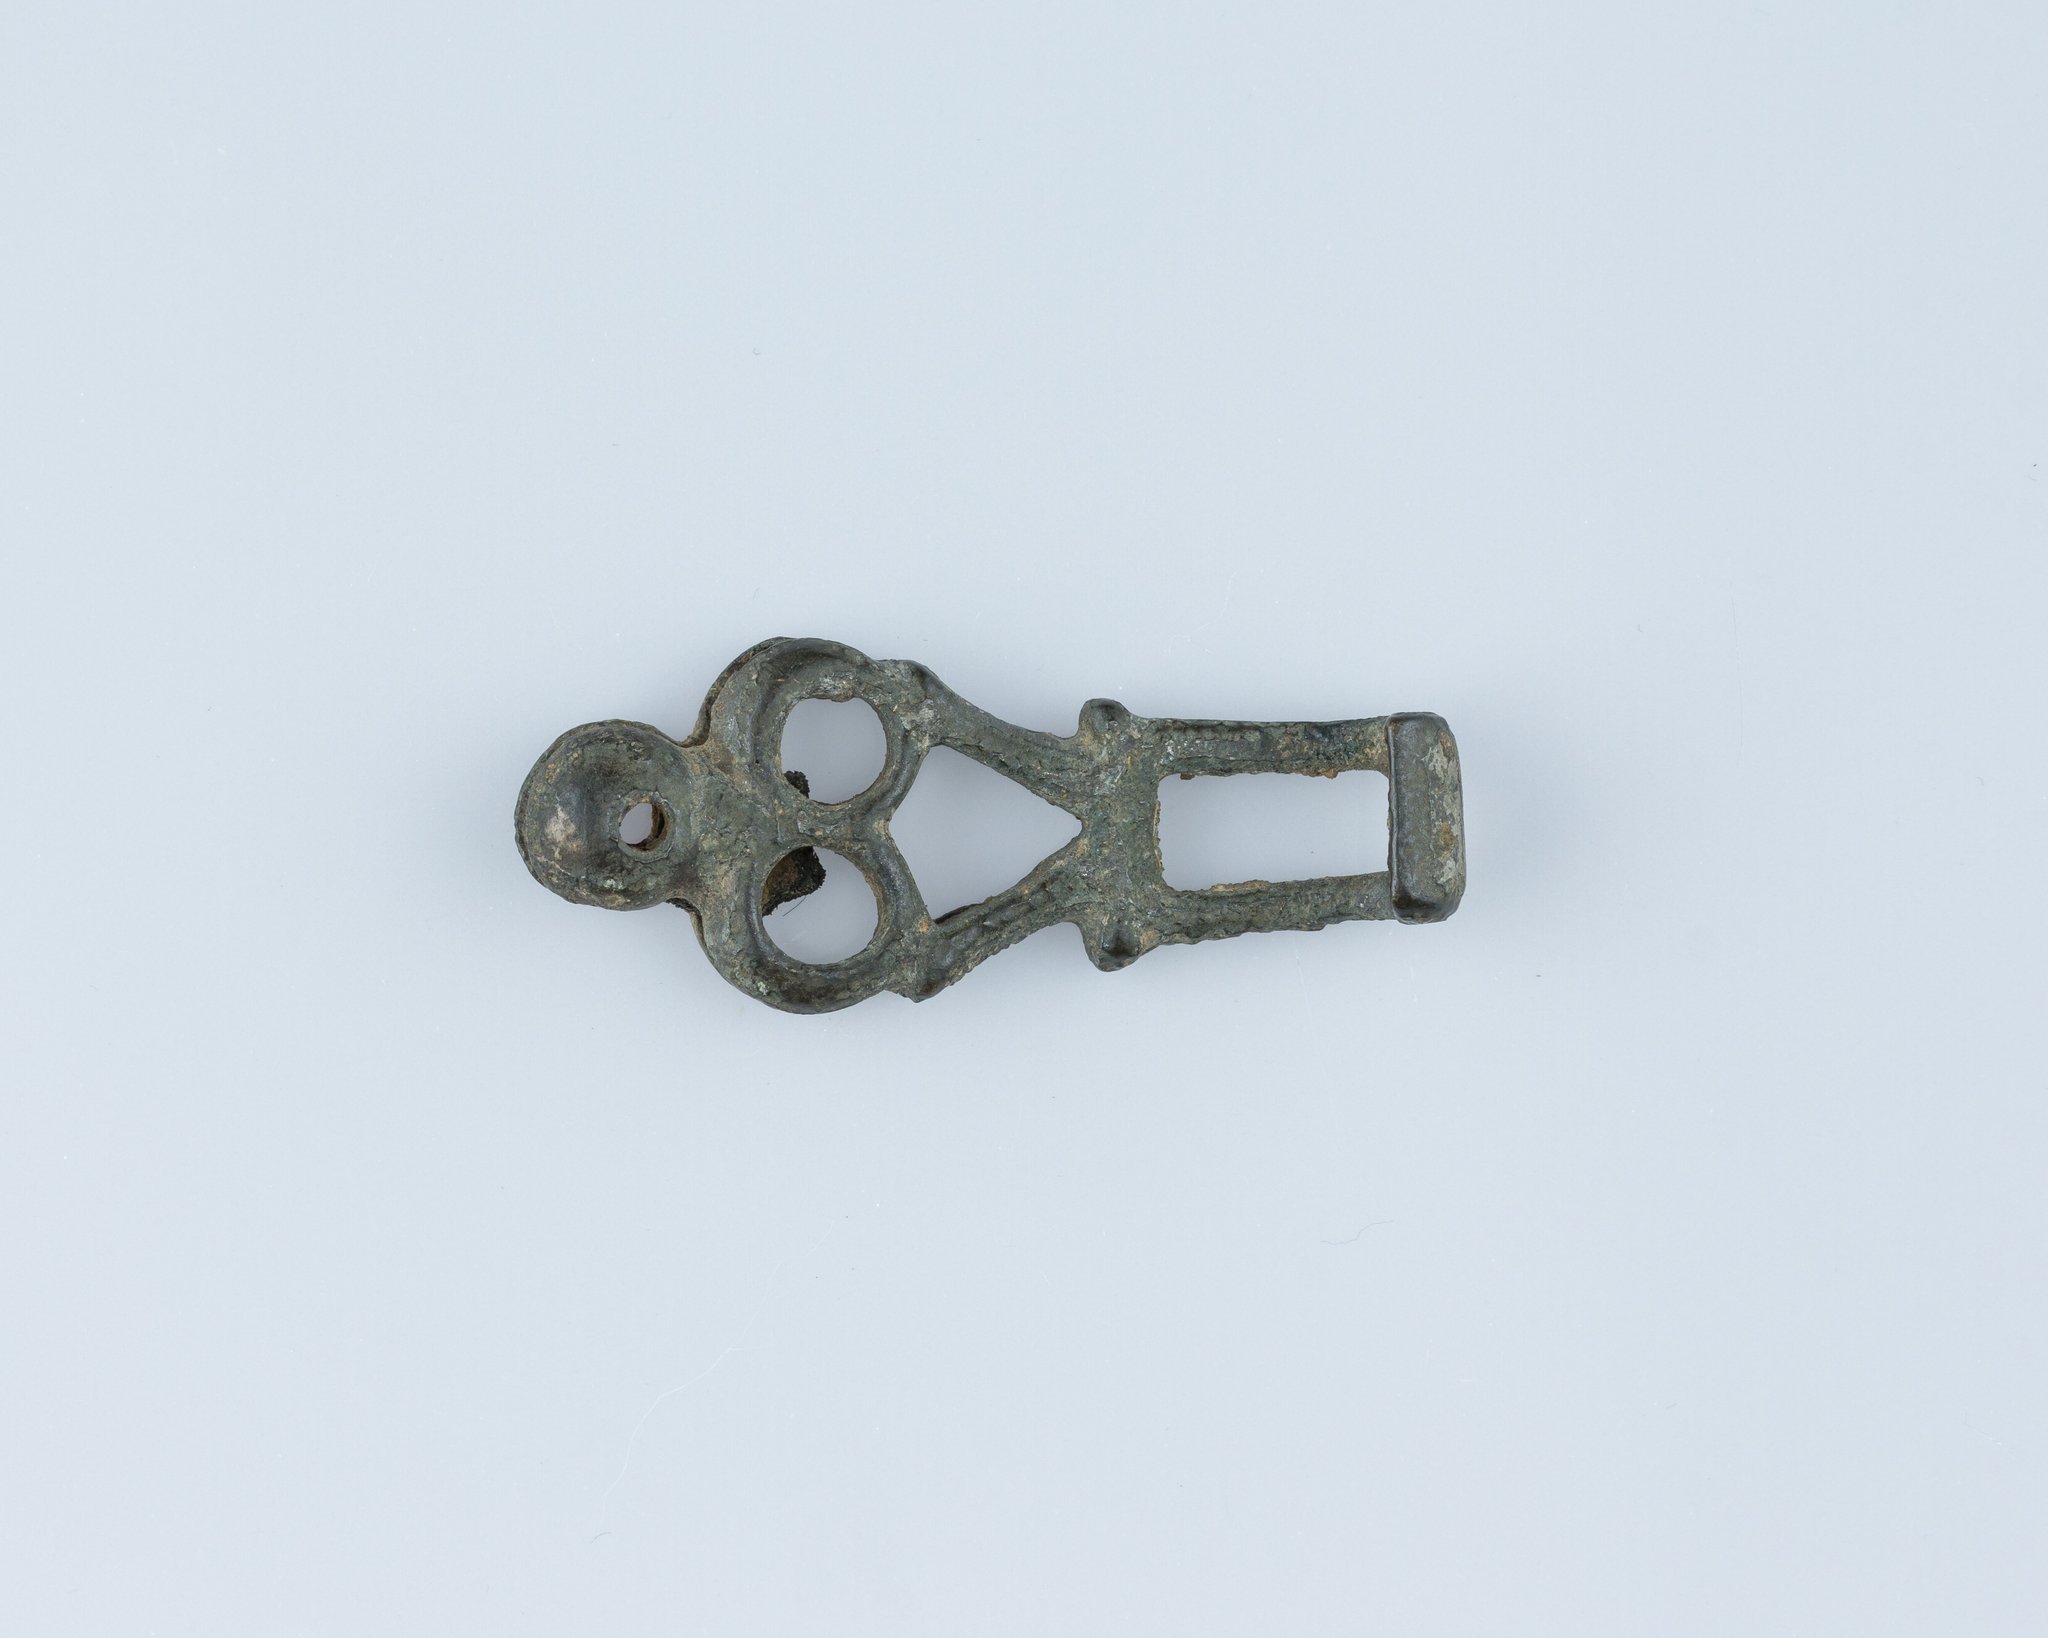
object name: pendant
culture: roman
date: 50 BCE-500 CE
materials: bronze